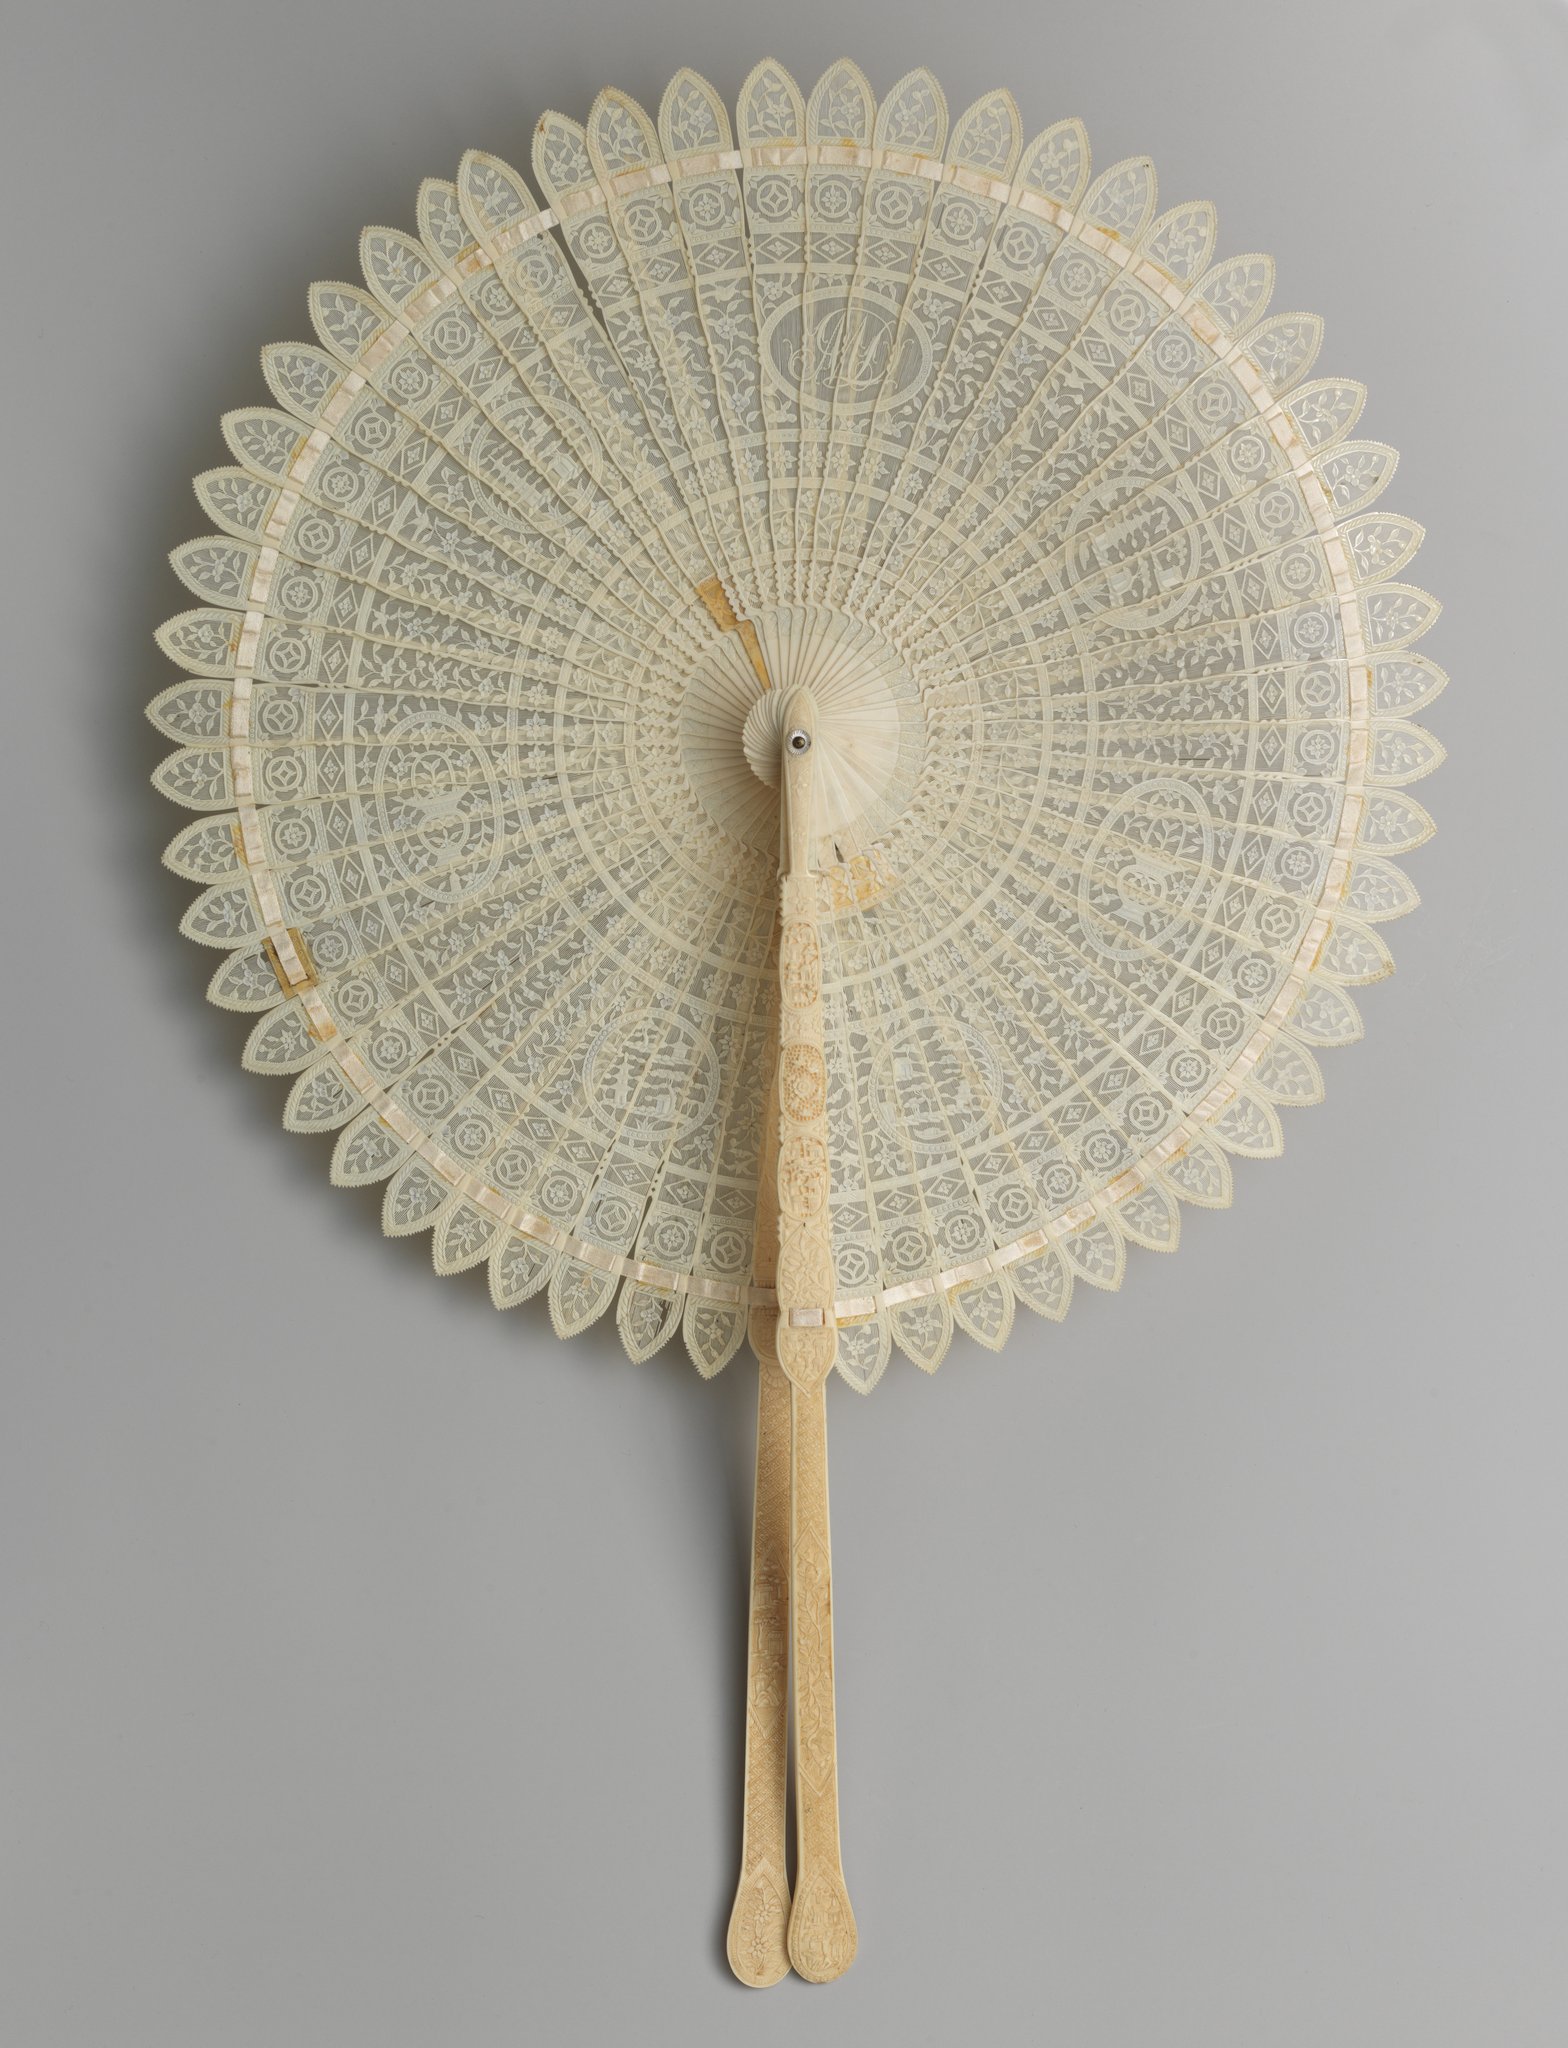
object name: fan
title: Brisé Cockade Fan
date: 1801-1900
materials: ivory